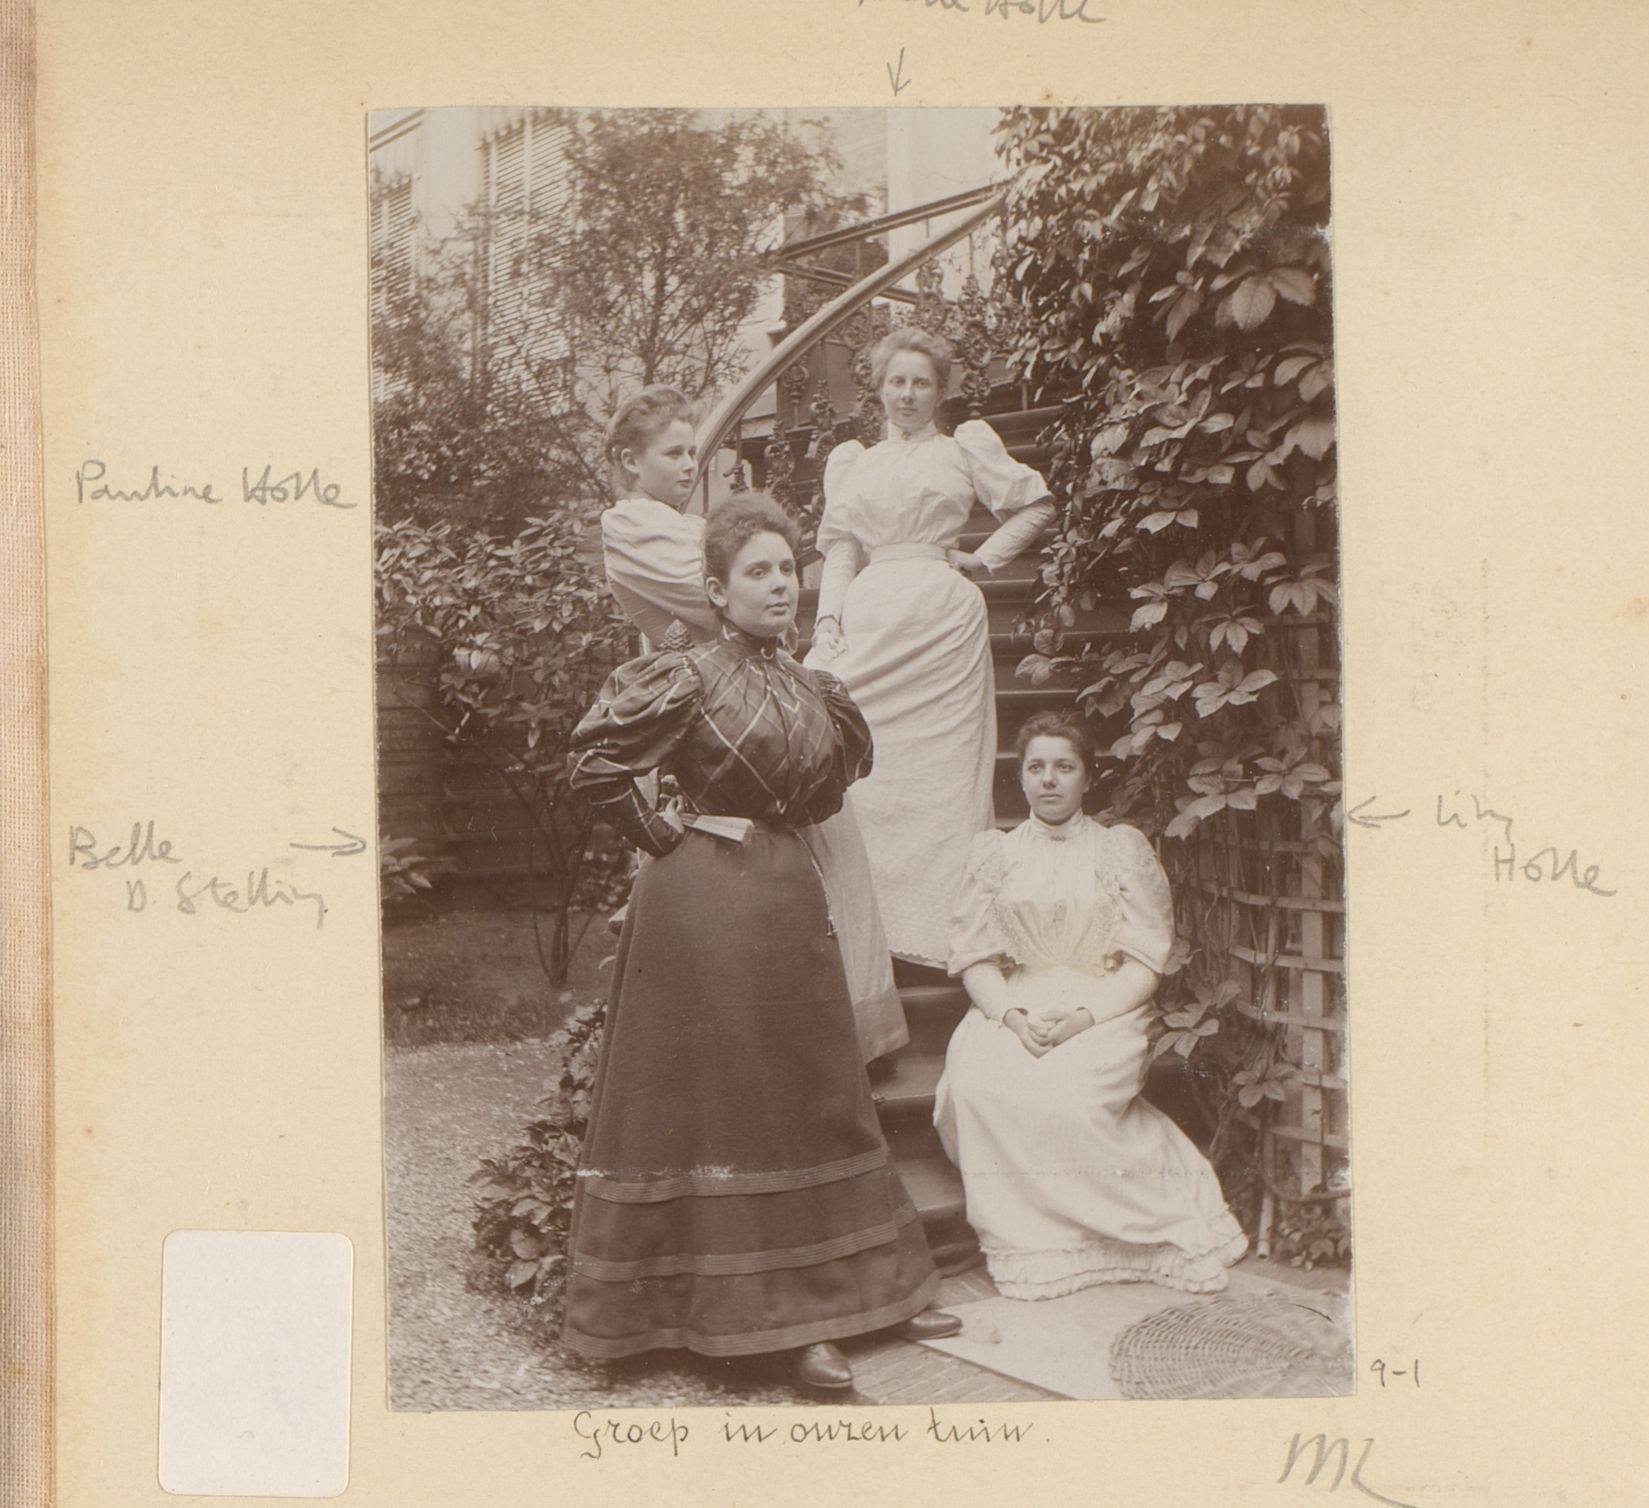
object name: photograph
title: Groep in onzen tuin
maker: hendrik herman van den berg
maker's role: amateurfotograaf, jurist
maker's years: 1875-1944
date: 1890-1894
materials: paper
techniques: collodion silver print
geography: amsterdam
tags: batavia, historical persons - bb - woman, amsterdam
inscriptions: caption: ‘Annie Holle/ Pauline Holle/ Belle D Stelling[?]/ [...] Holle’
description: Foto 1 op albumblad 9 uit album "Amsterdam 1890-1894".